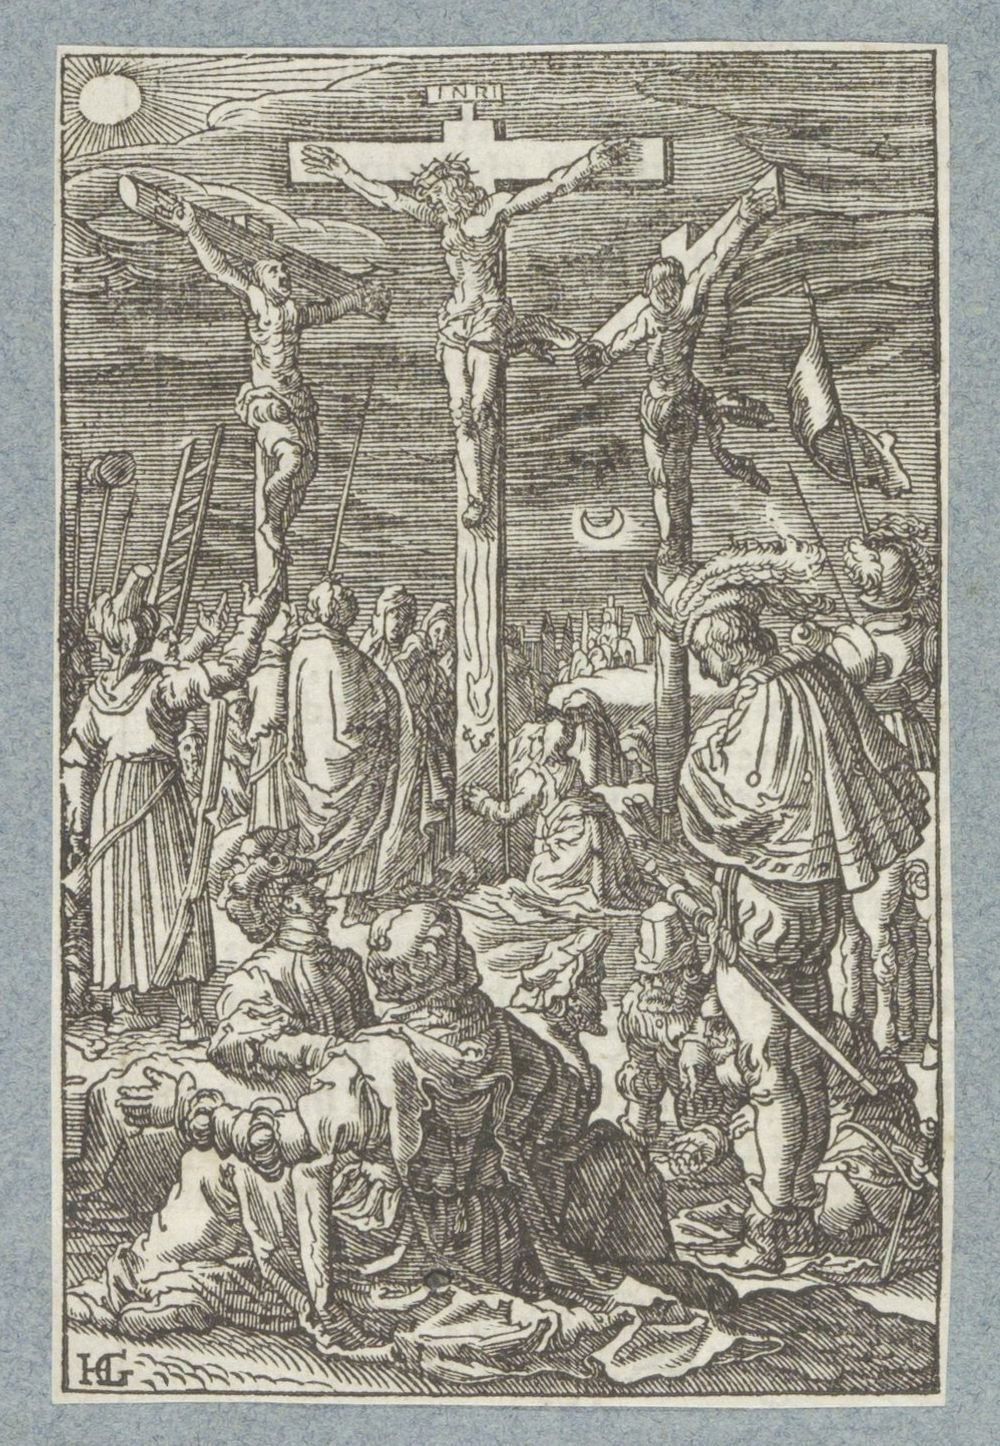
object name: album leaf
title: Christus aan het kruis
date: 1629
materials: paper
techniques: letterpress printing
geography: amsterdam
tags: the crucifixion of christ: christ's death on the cross; golgotha (matthew 27:45-58; mark 15:33-45; luke 23:44-52; john 19:25-38)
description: De prent is afkomstig uit een van de uitgaven van P.J. Paets uit Amsterdam. De prent wordt voor het eerst gebruikt in: Der Zielen Lust-hof. Leuven, I.Jacbosz voor P.J. Paets [= Amsterdam, P.J. Paets], 1629. De voorstelling is gekopieerd naar een prent van Hendrick Goltzius.